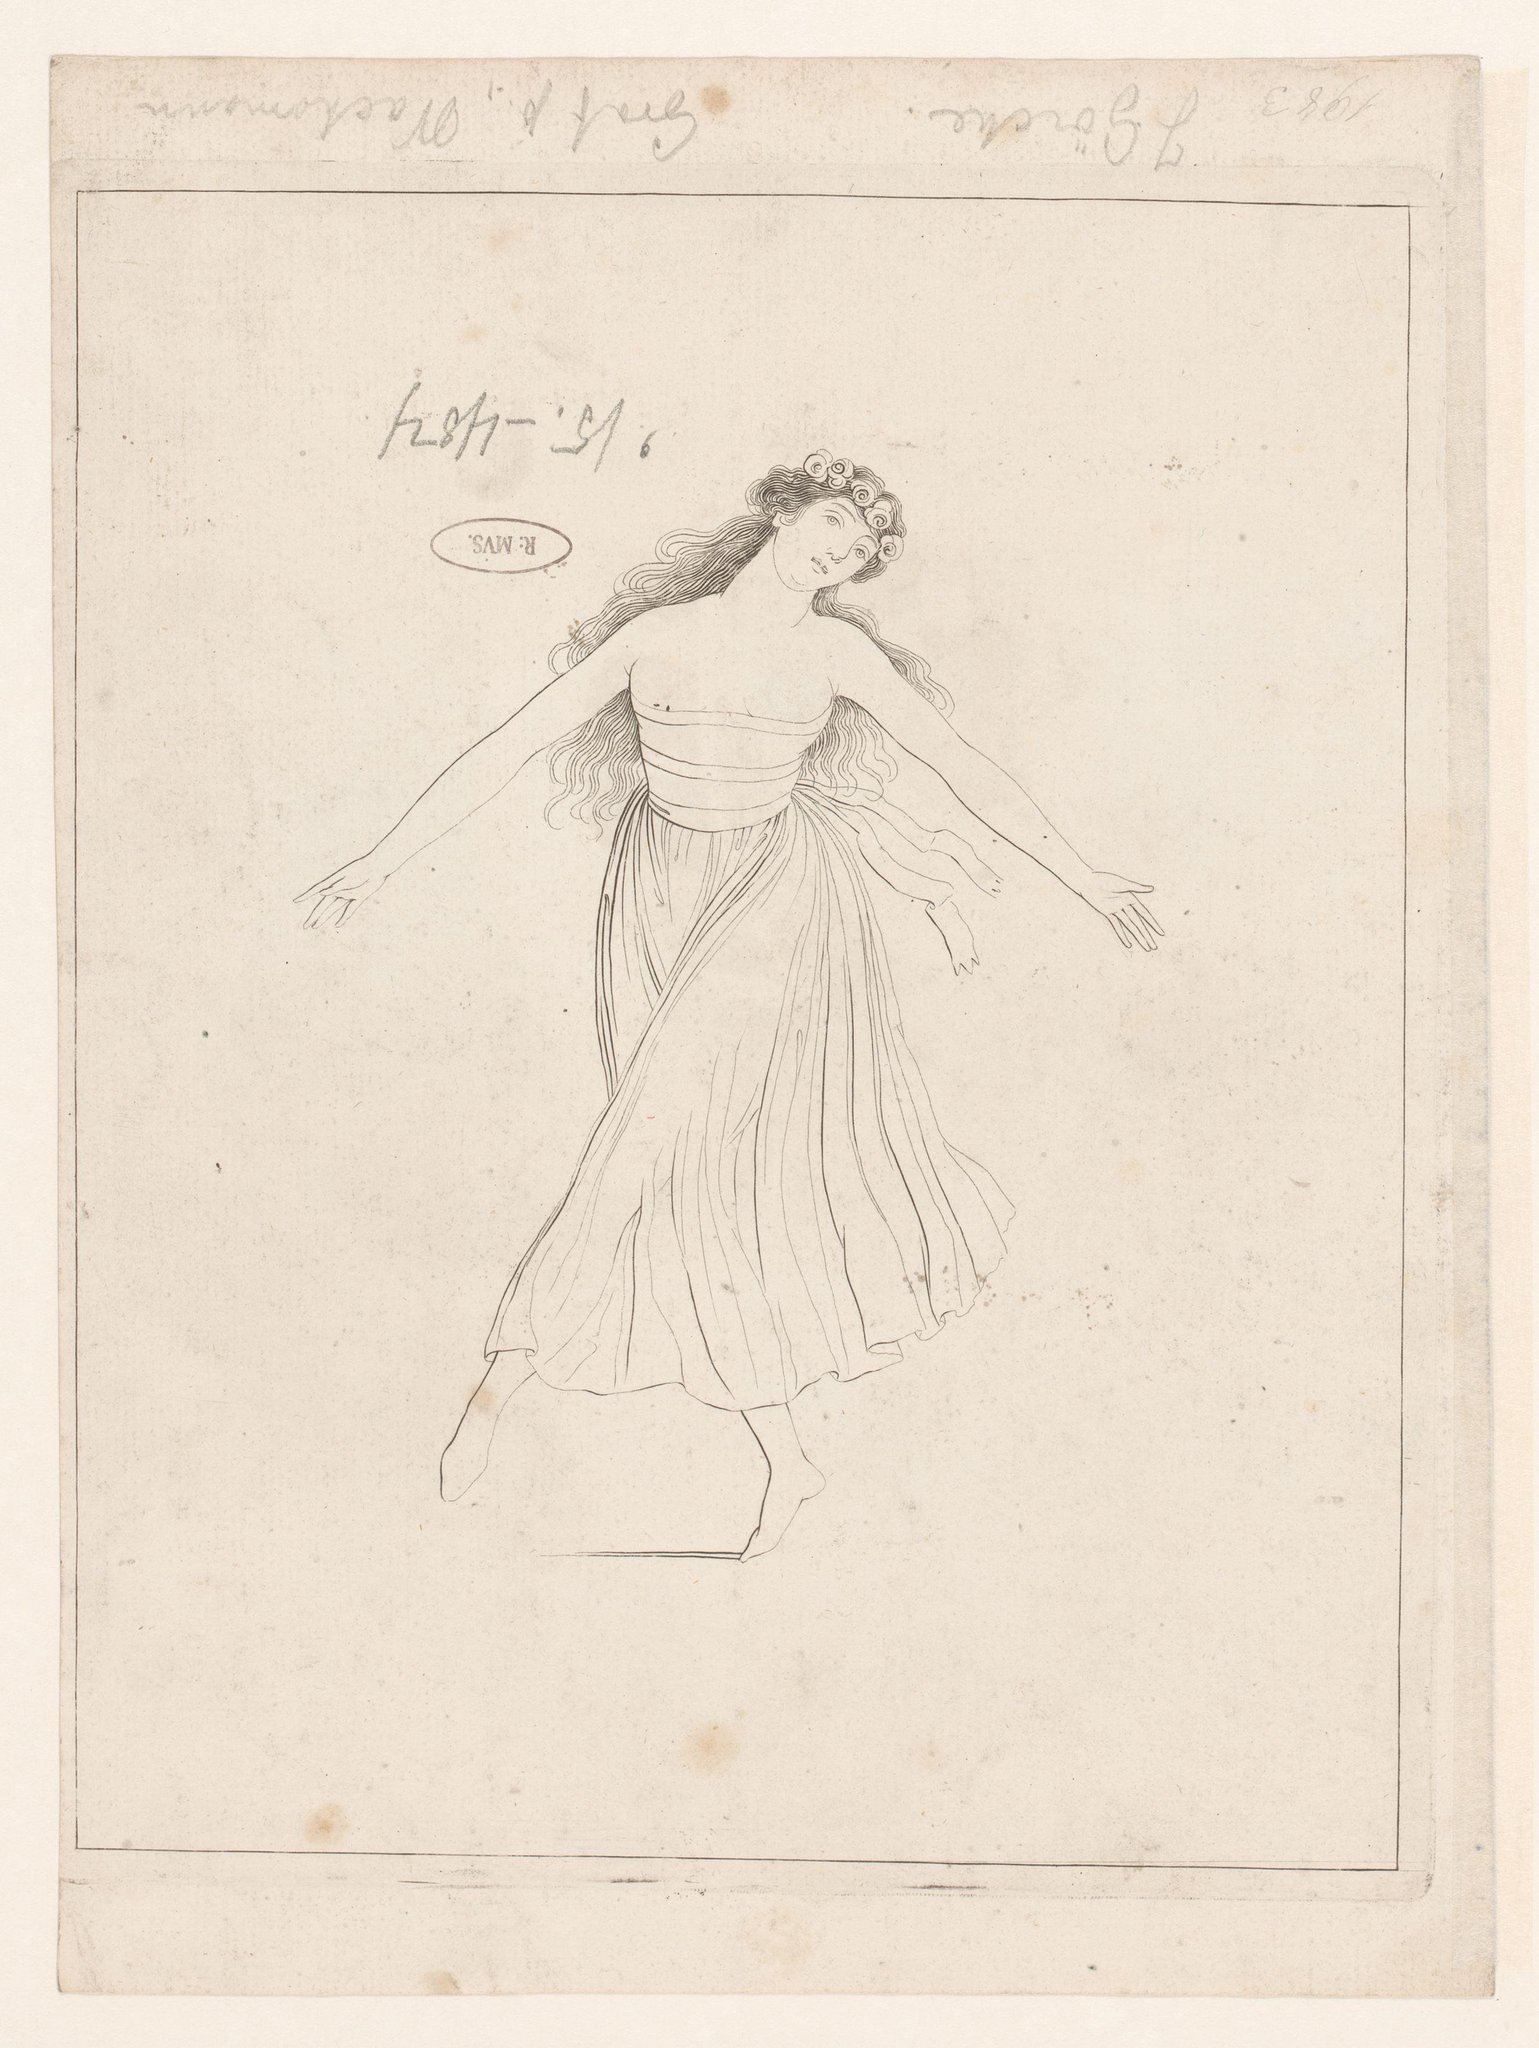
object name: print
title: Dansende vrouw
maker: Anonymous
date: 1750-1799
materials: paper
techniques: etching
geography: germany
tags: adolescent, young woman, maiden, woman dancing alone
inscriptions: collector's mark: Lugt 2228